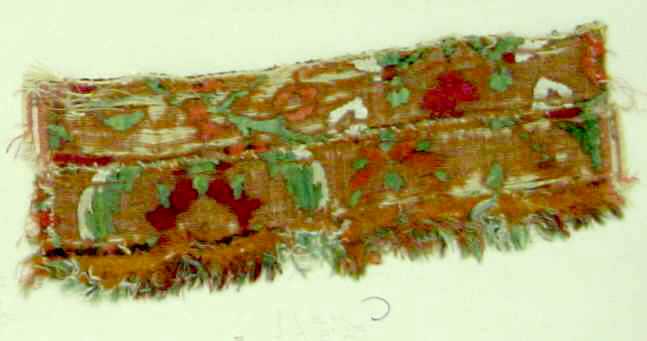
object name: textile fragment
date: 1601-1633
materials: silk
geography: iran